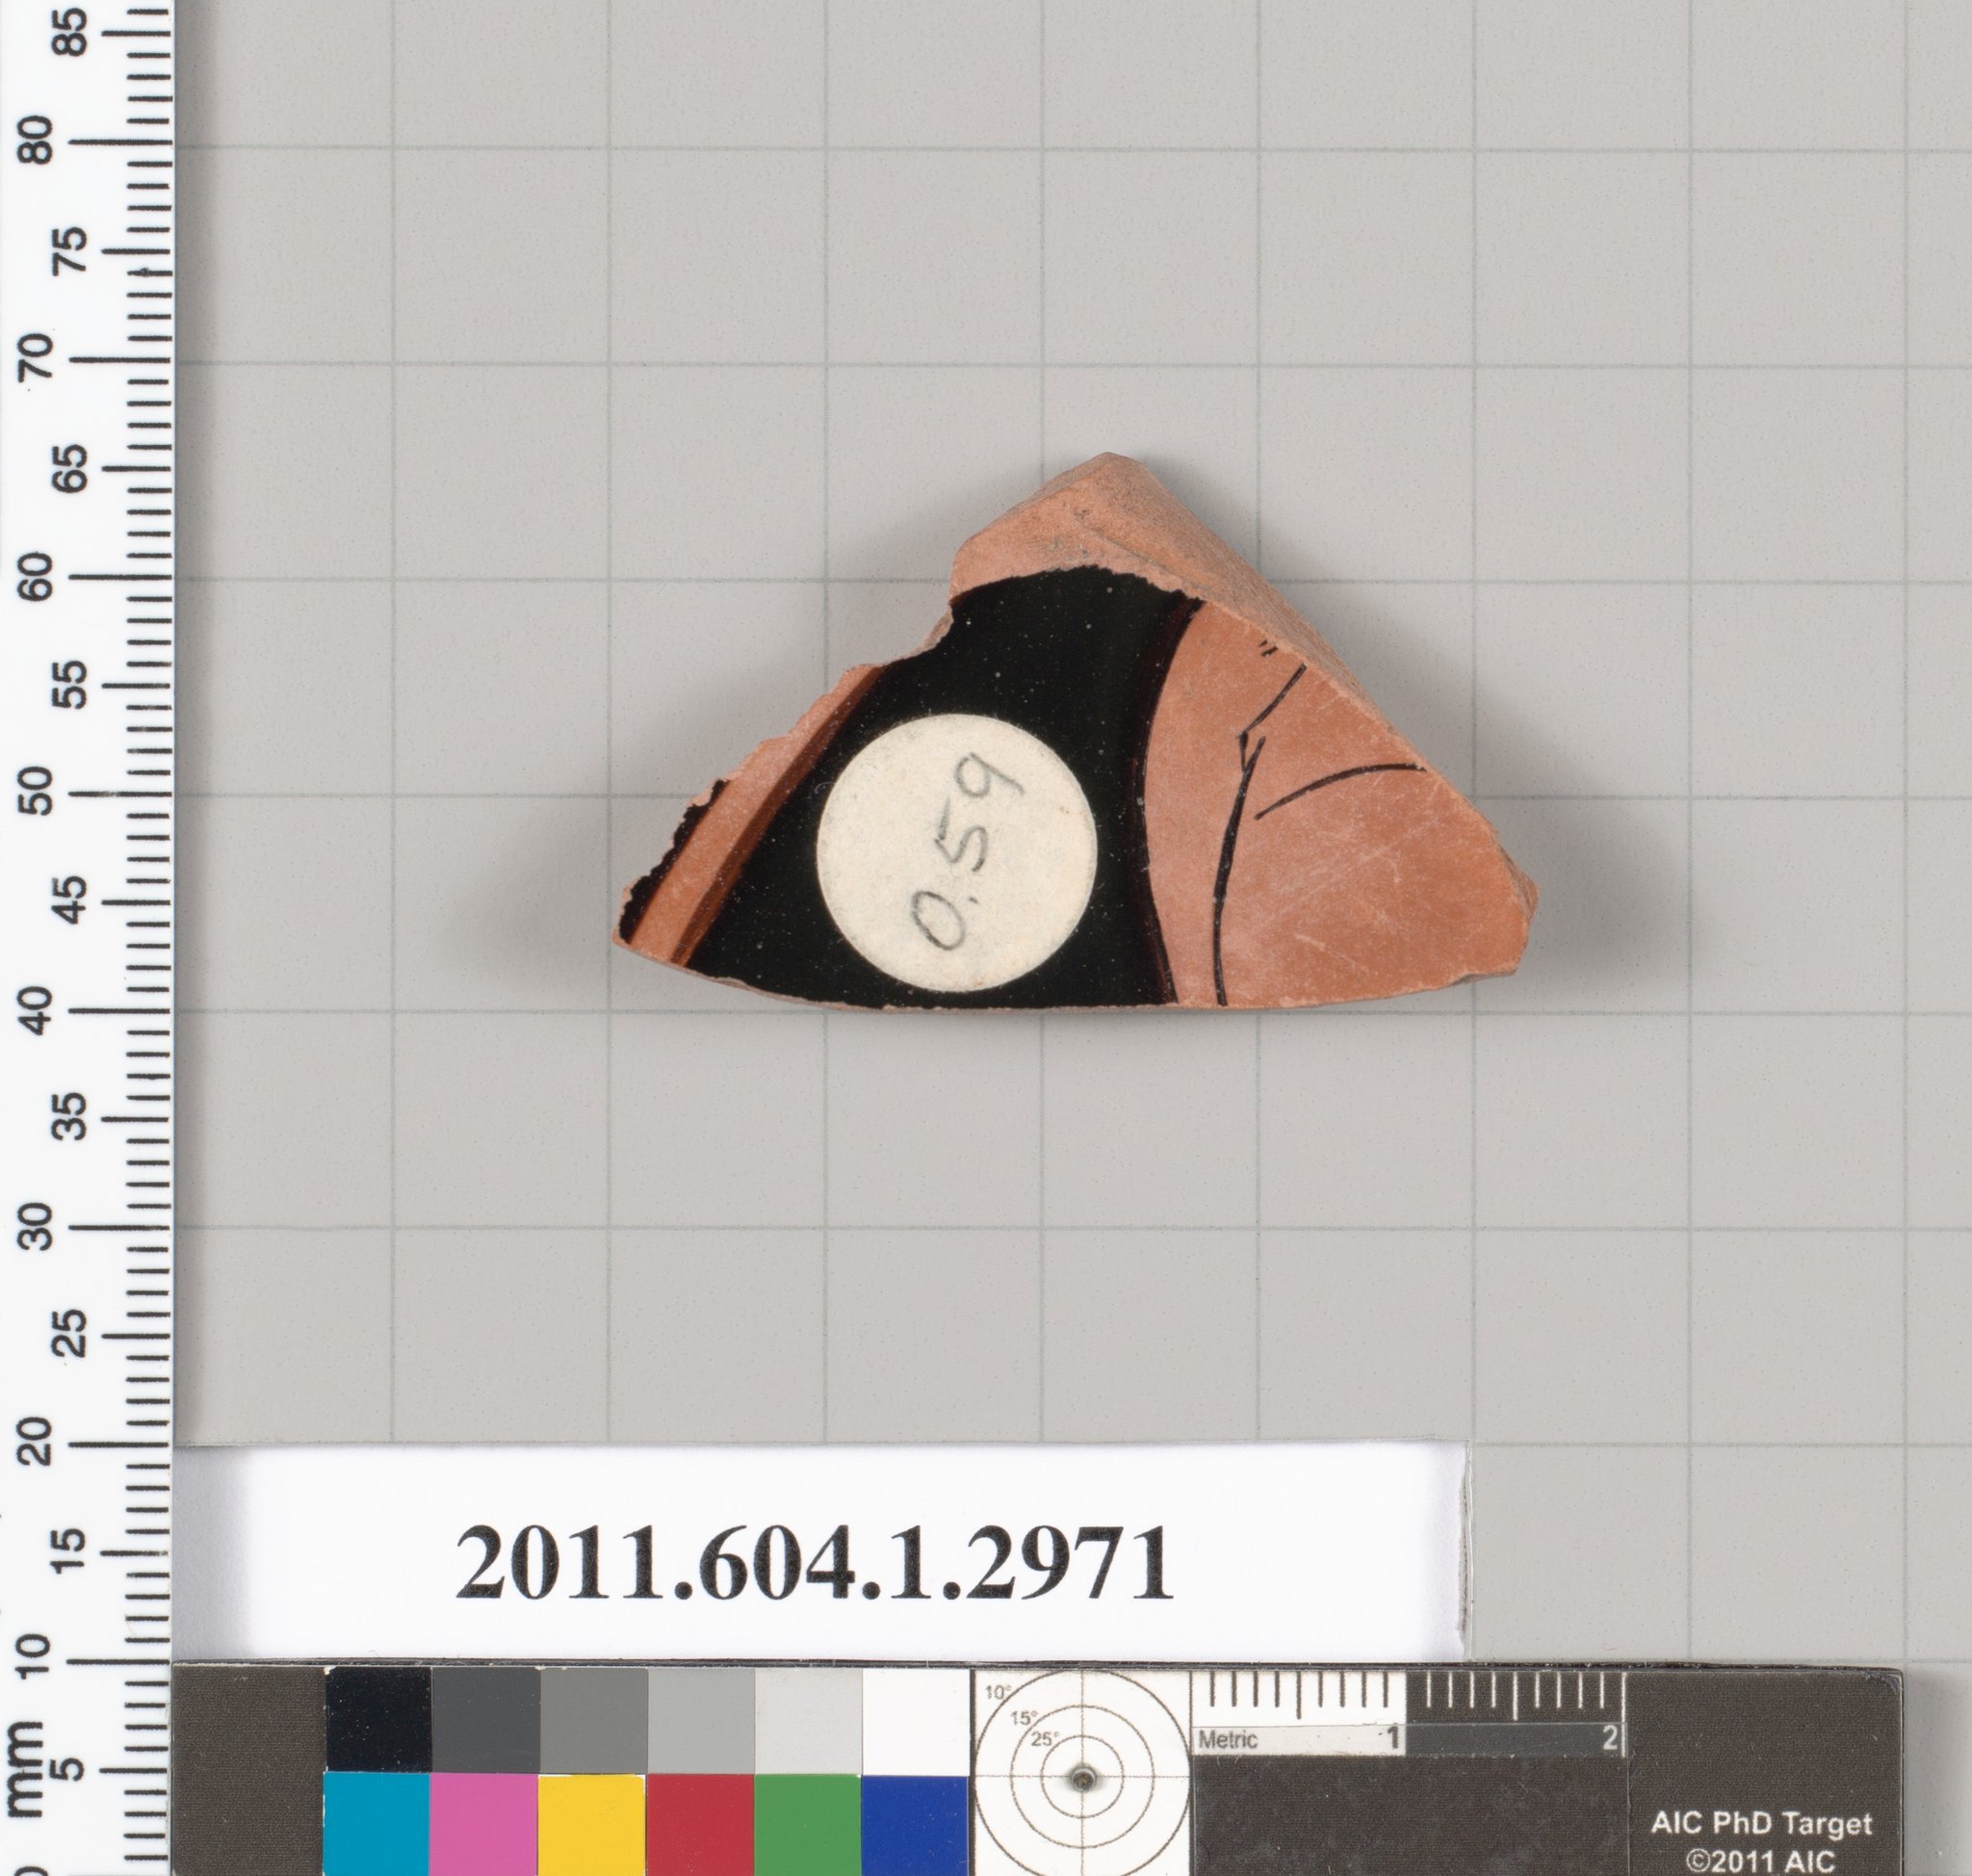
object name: kylix fragment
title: Terracotta fragment of a kylix (drinking cup)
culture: greek, attic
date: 520-490 BCE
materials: terracotta